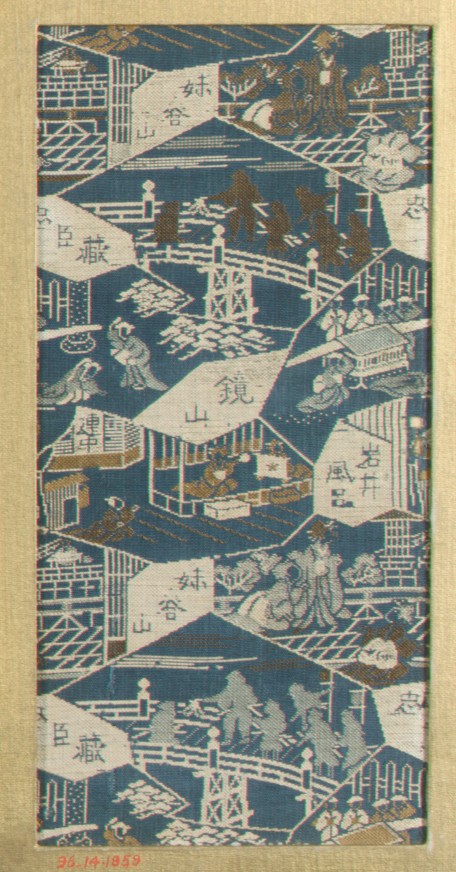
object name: piece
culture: japanese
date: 1701-1900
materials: silk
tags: human figures,houses